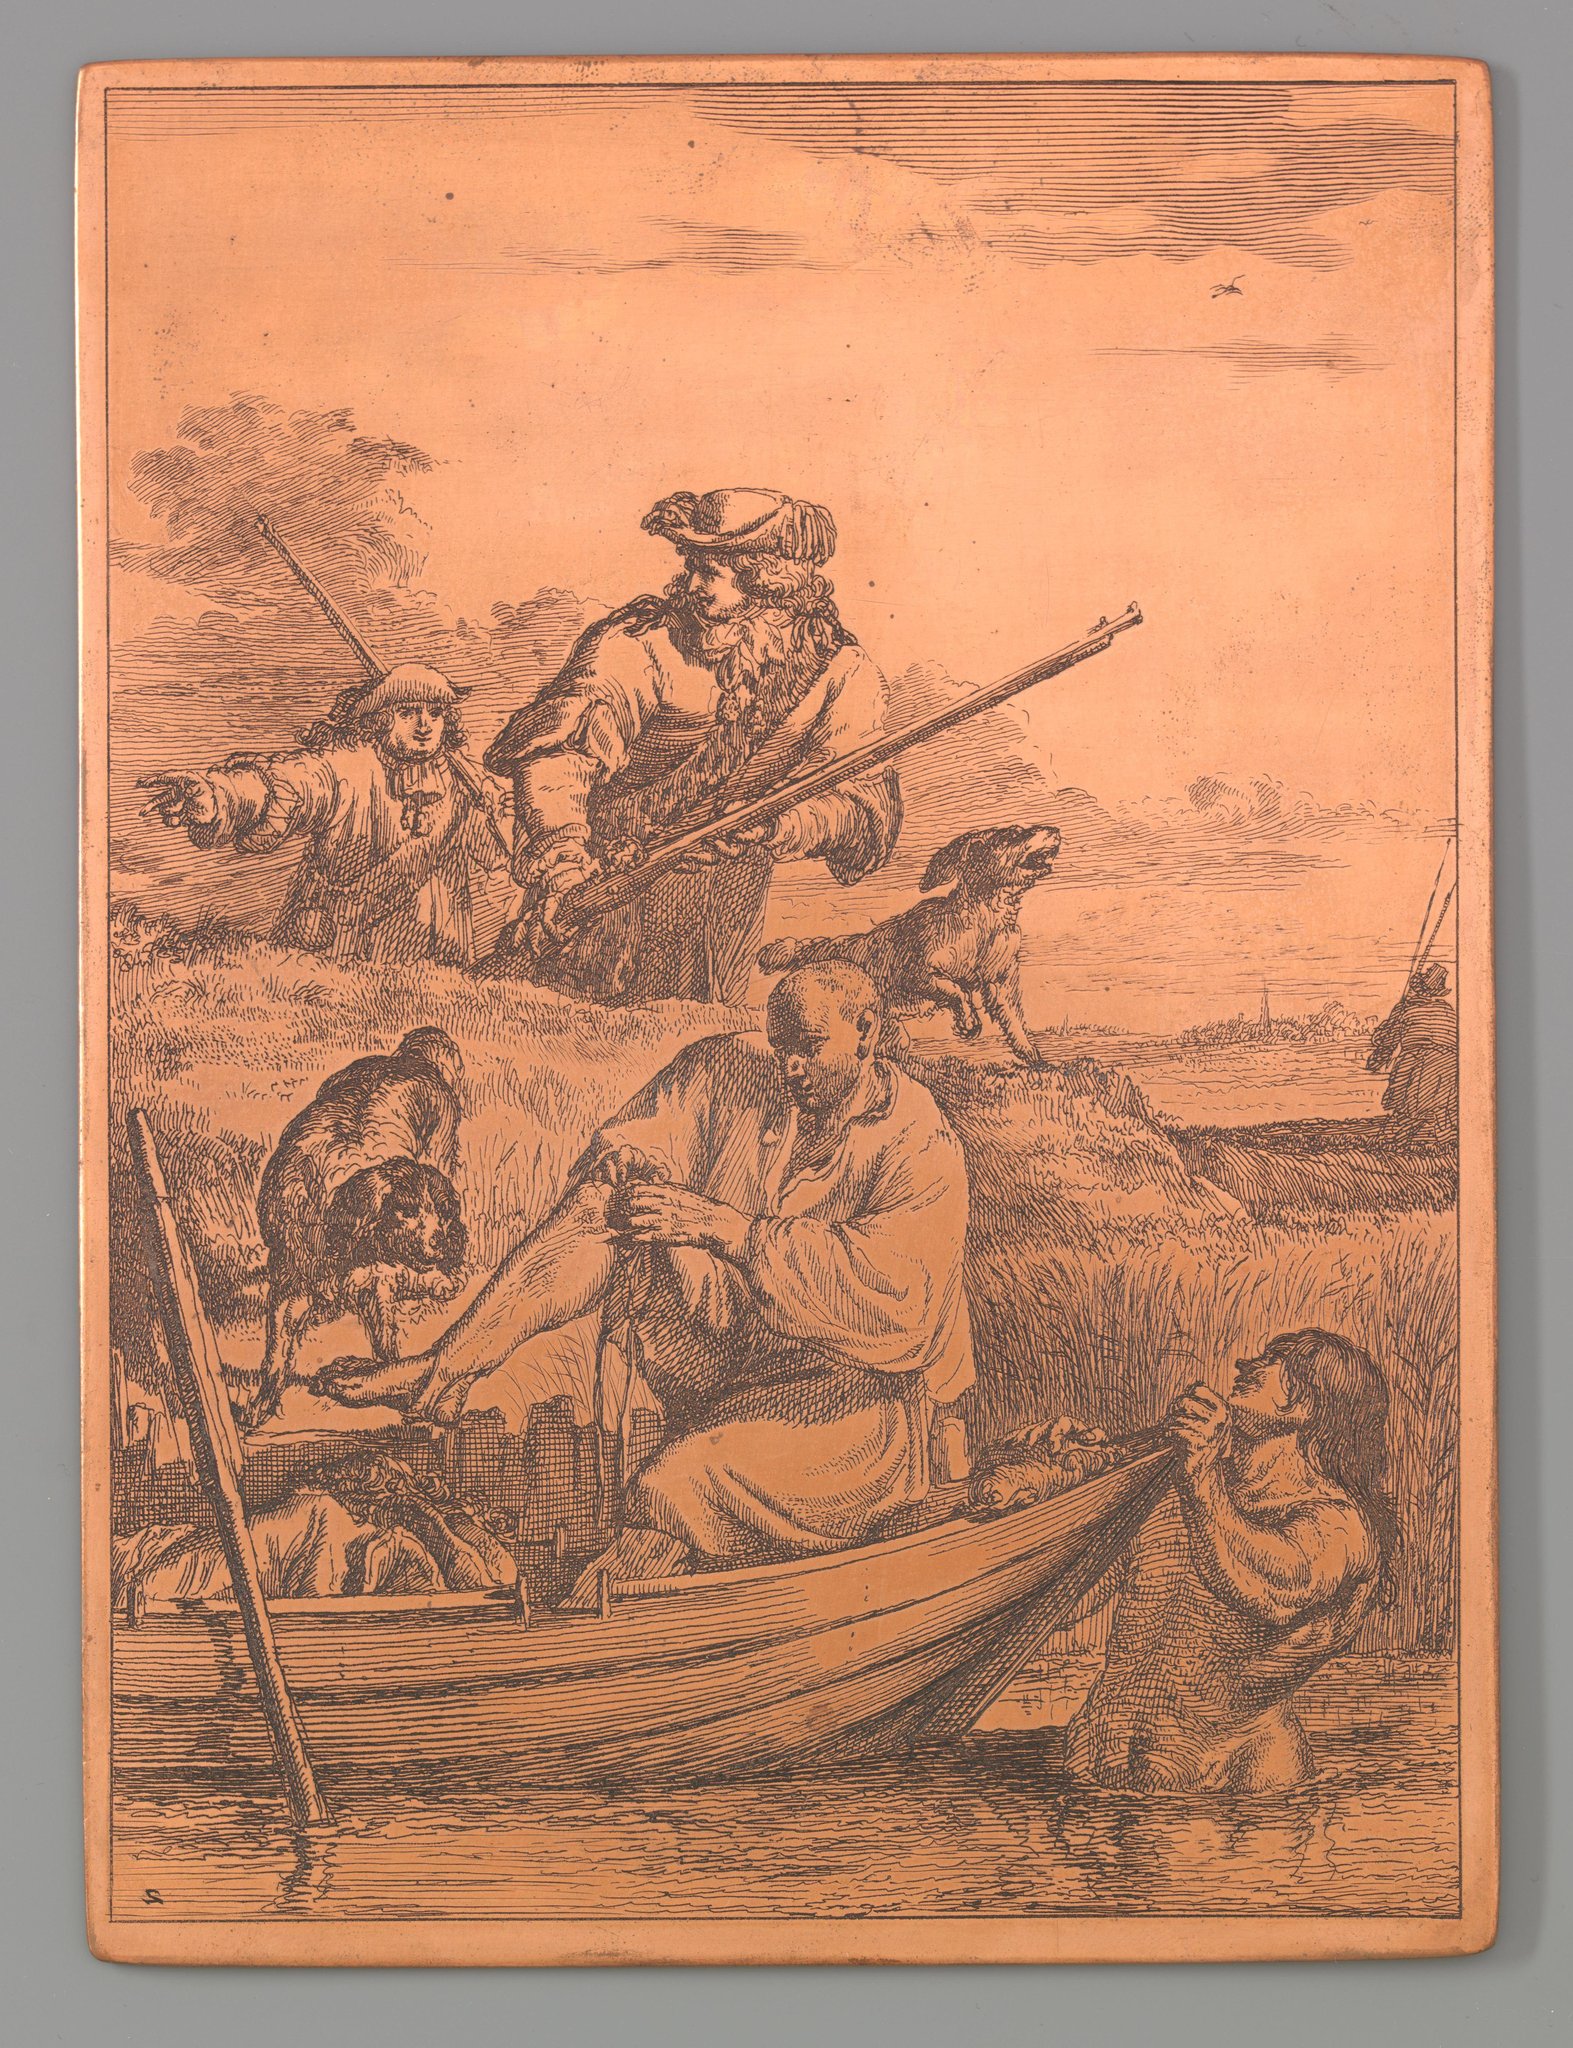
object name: copper plate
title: De jacht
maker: romeyn de hooghe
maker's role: draughtsman, goldsmith, painter, print maker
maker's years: 1645-1708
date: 1663-1683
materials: copper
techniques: etching